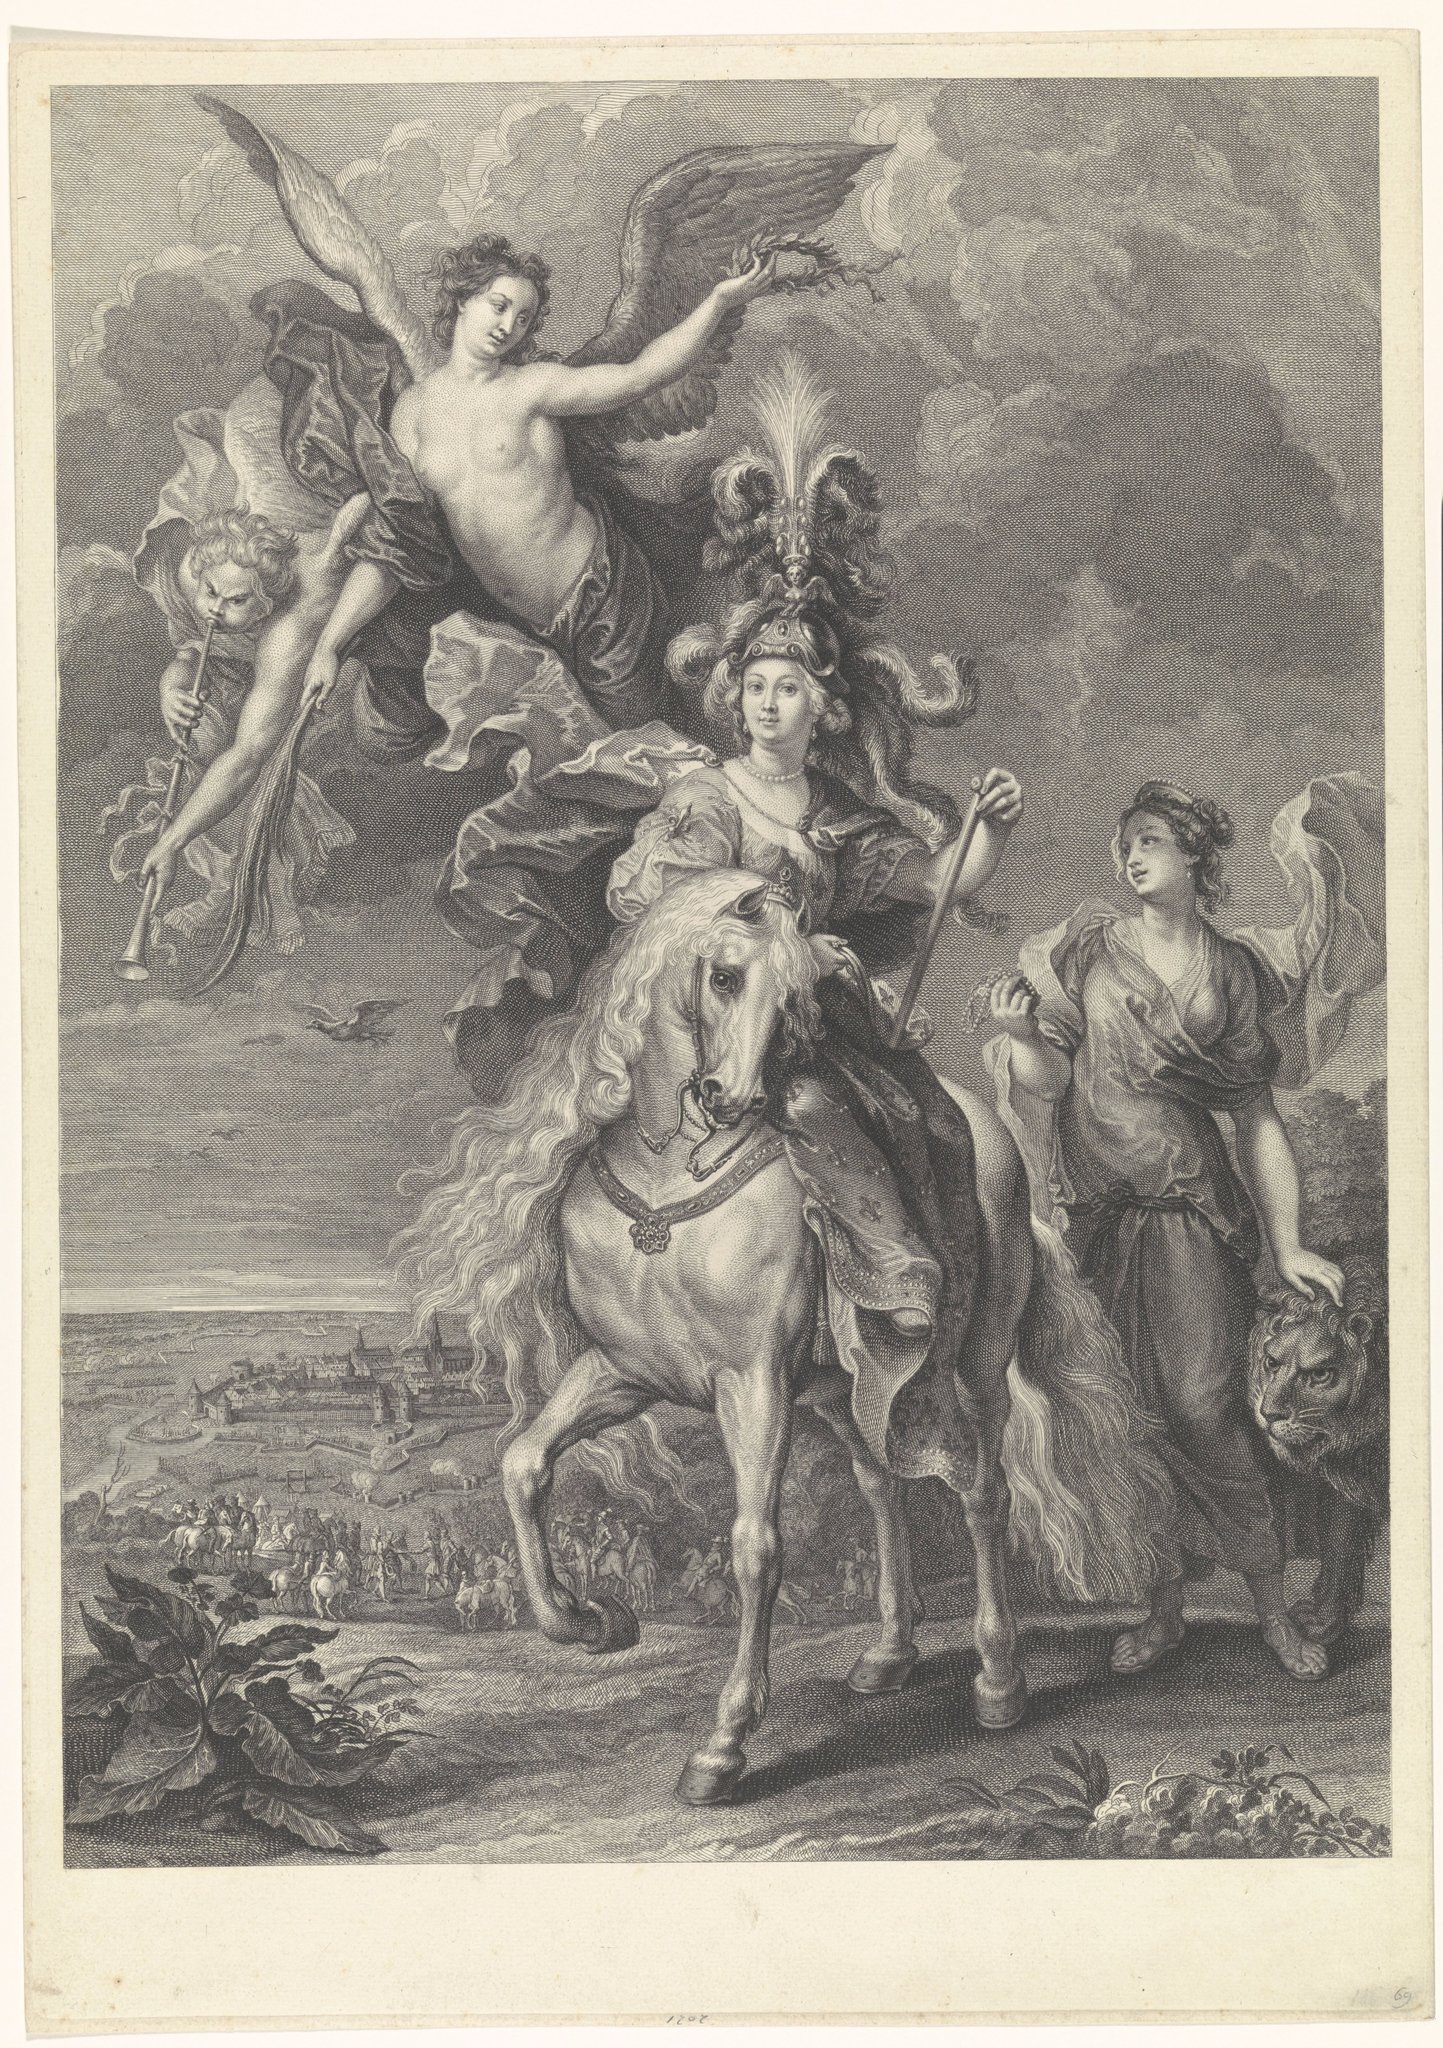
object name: print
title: Allegorisch portret van Maria de' Medici met de inname van Gulik, 1610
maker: bernard picart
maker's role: draughtsman, print maker, publisher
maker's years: 1673-1733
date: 1707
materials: paper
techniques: engraving, etching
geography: amsterdam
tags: print maker, maria de' medici, 'victoria'; 'vittoria', 'vittoria navale', 'vittoria degl'antichi' (ripa), crowning with laurel, fame; 'fama', 'fama buona', 'fama chiara' (ripa), generosity, liberality; 'generosità', 'liberalità' (ripa)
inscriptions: inscription: ‘27 pag 62 = g’, collector's mark: Lugt 240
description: Faam blaast op de bazuin terwijl Victoria Maria de' Medici lauwert. De vorstin zit triomferend op haar paard met een commandostaf in de hand. De personificatie van Vrijgevigheid (Liberalitas) brengt haar juwelen. Op de achtergrond de inname van Gulik door prins Maurits en de vorst van Anhalt, op 2 september 1610.